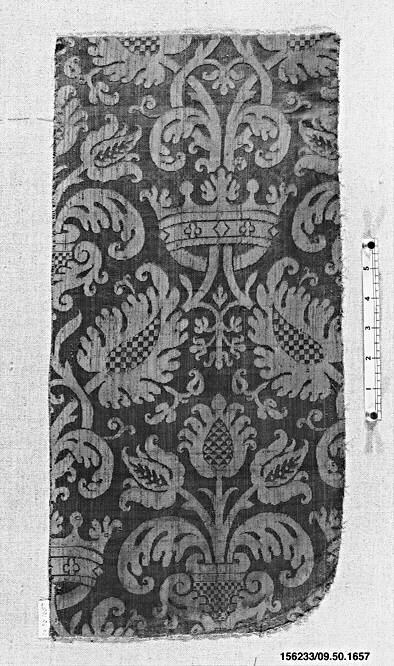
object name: piece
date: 1501-1600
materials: silk